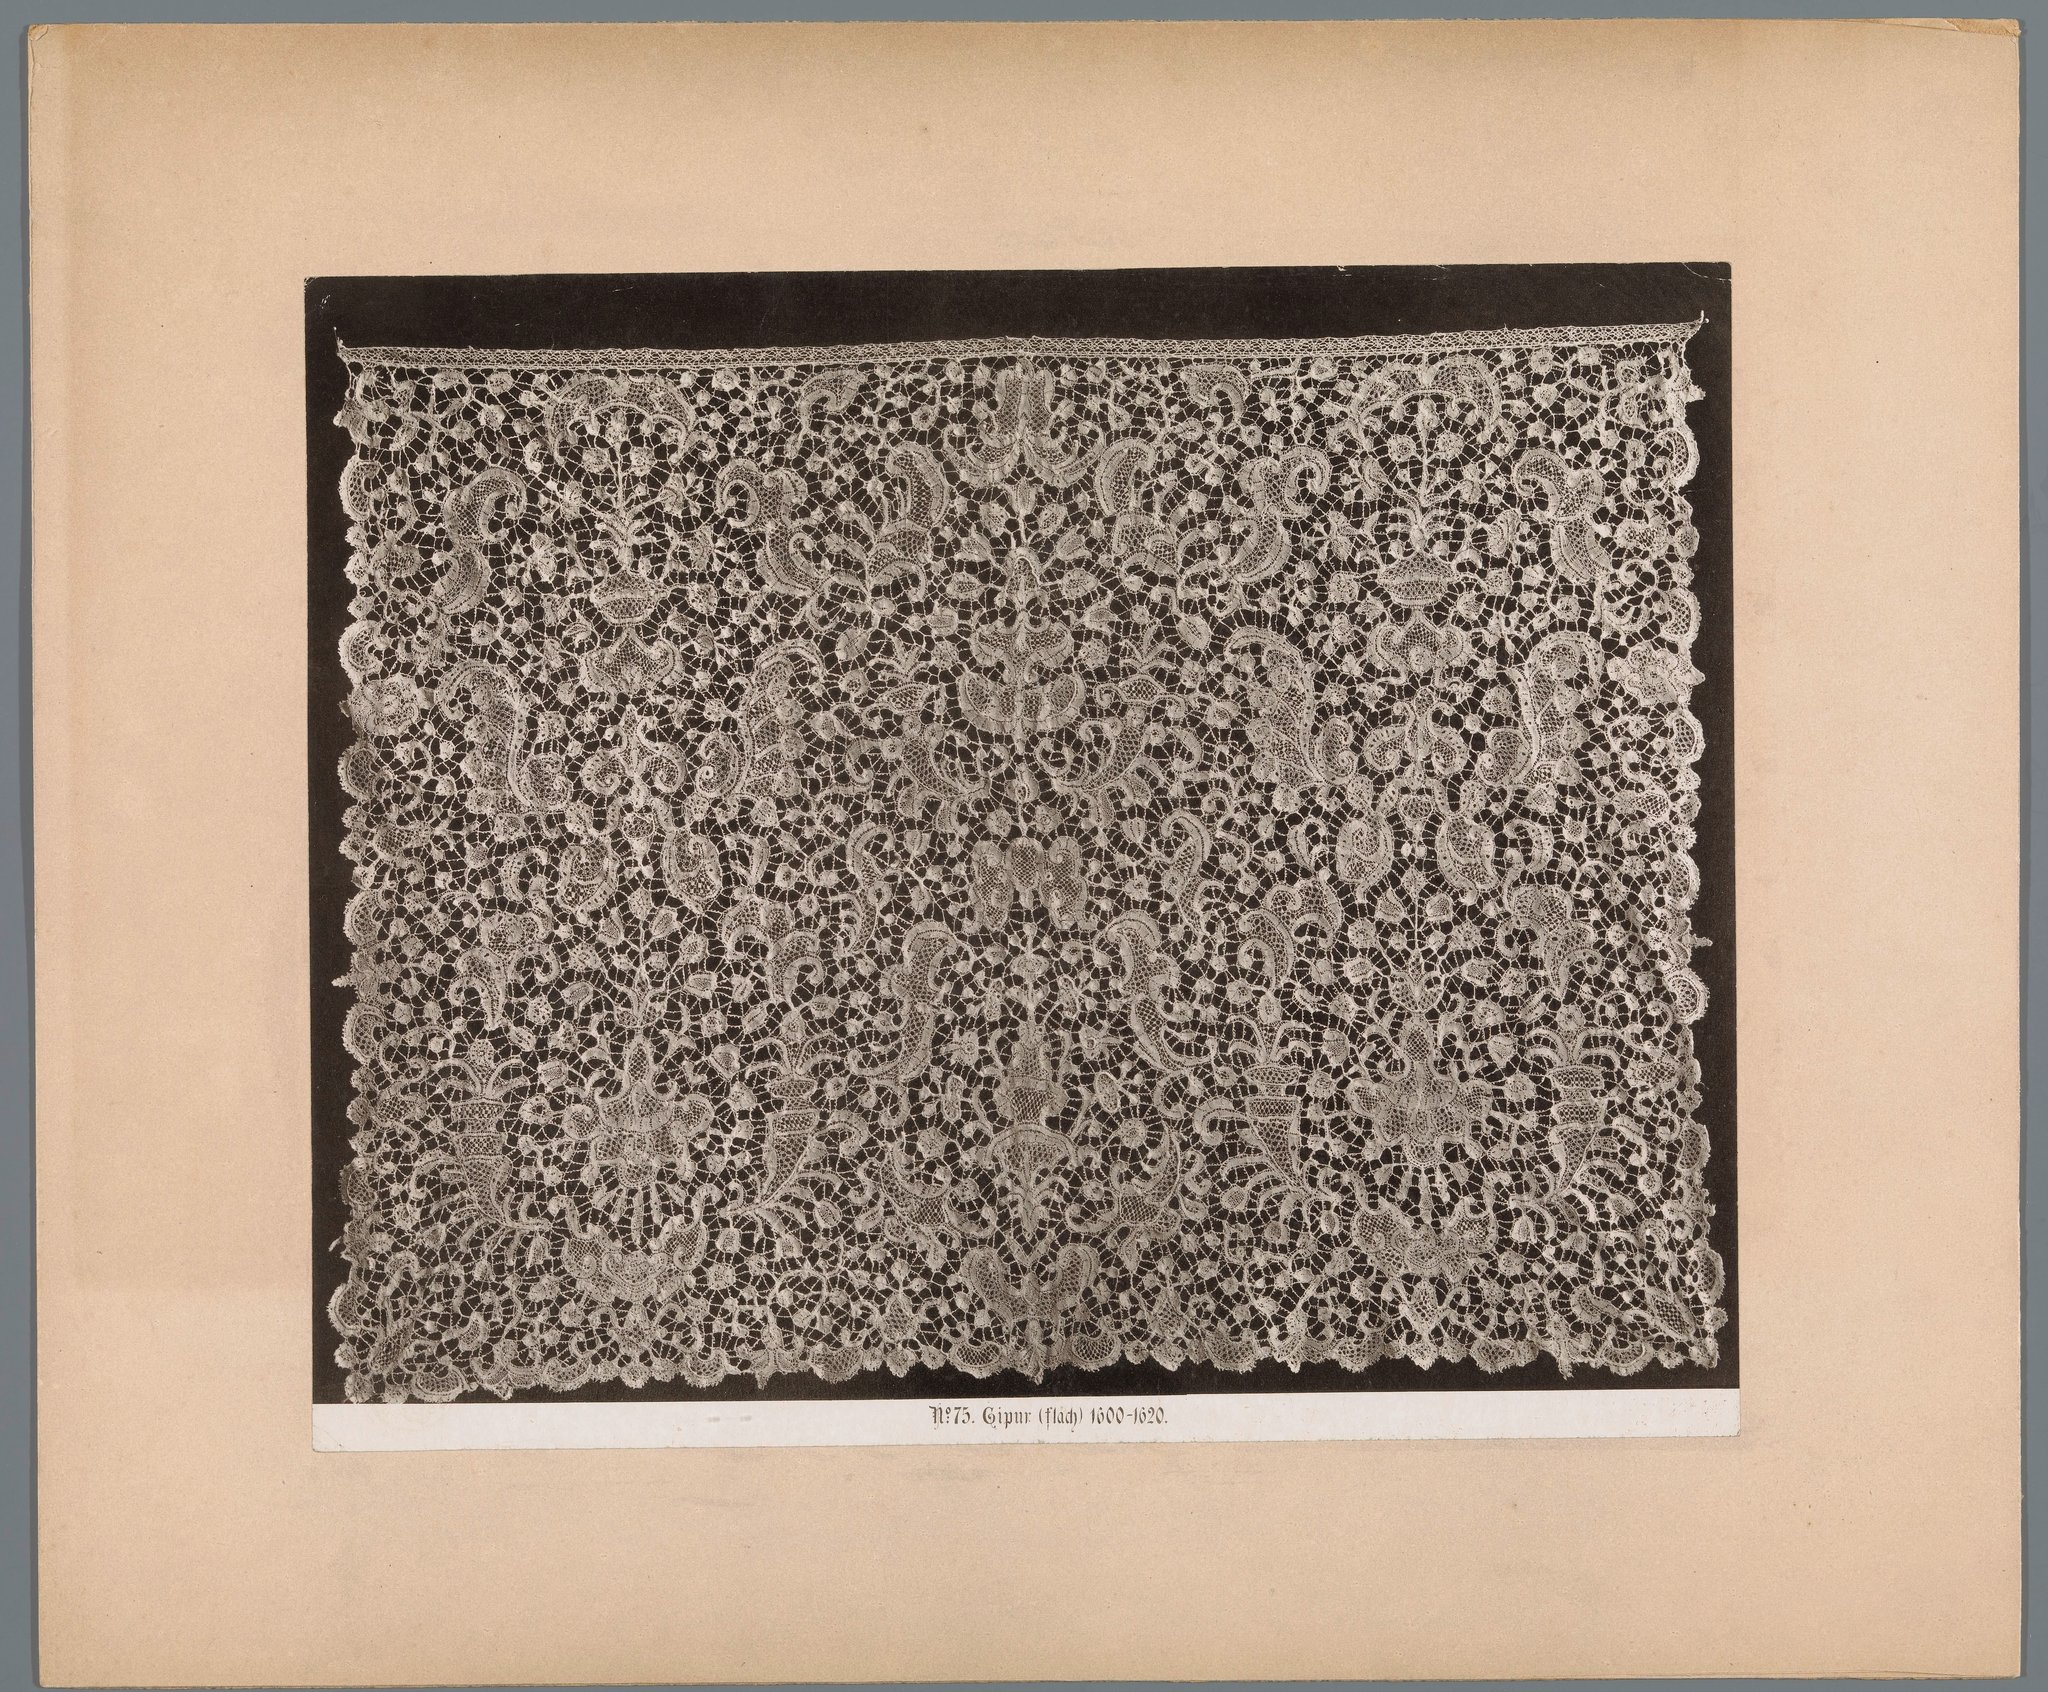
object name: photograph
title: Gipur (flach) 1600-1620.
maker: Anonymous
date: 1875-1900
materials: cardboard, paper, ink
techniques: photograph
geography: europe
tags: lace, europe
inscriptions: collector's mark: Lugt 3937, inscription: ‘[...] National-Museum’, number: ‘No. 75.’